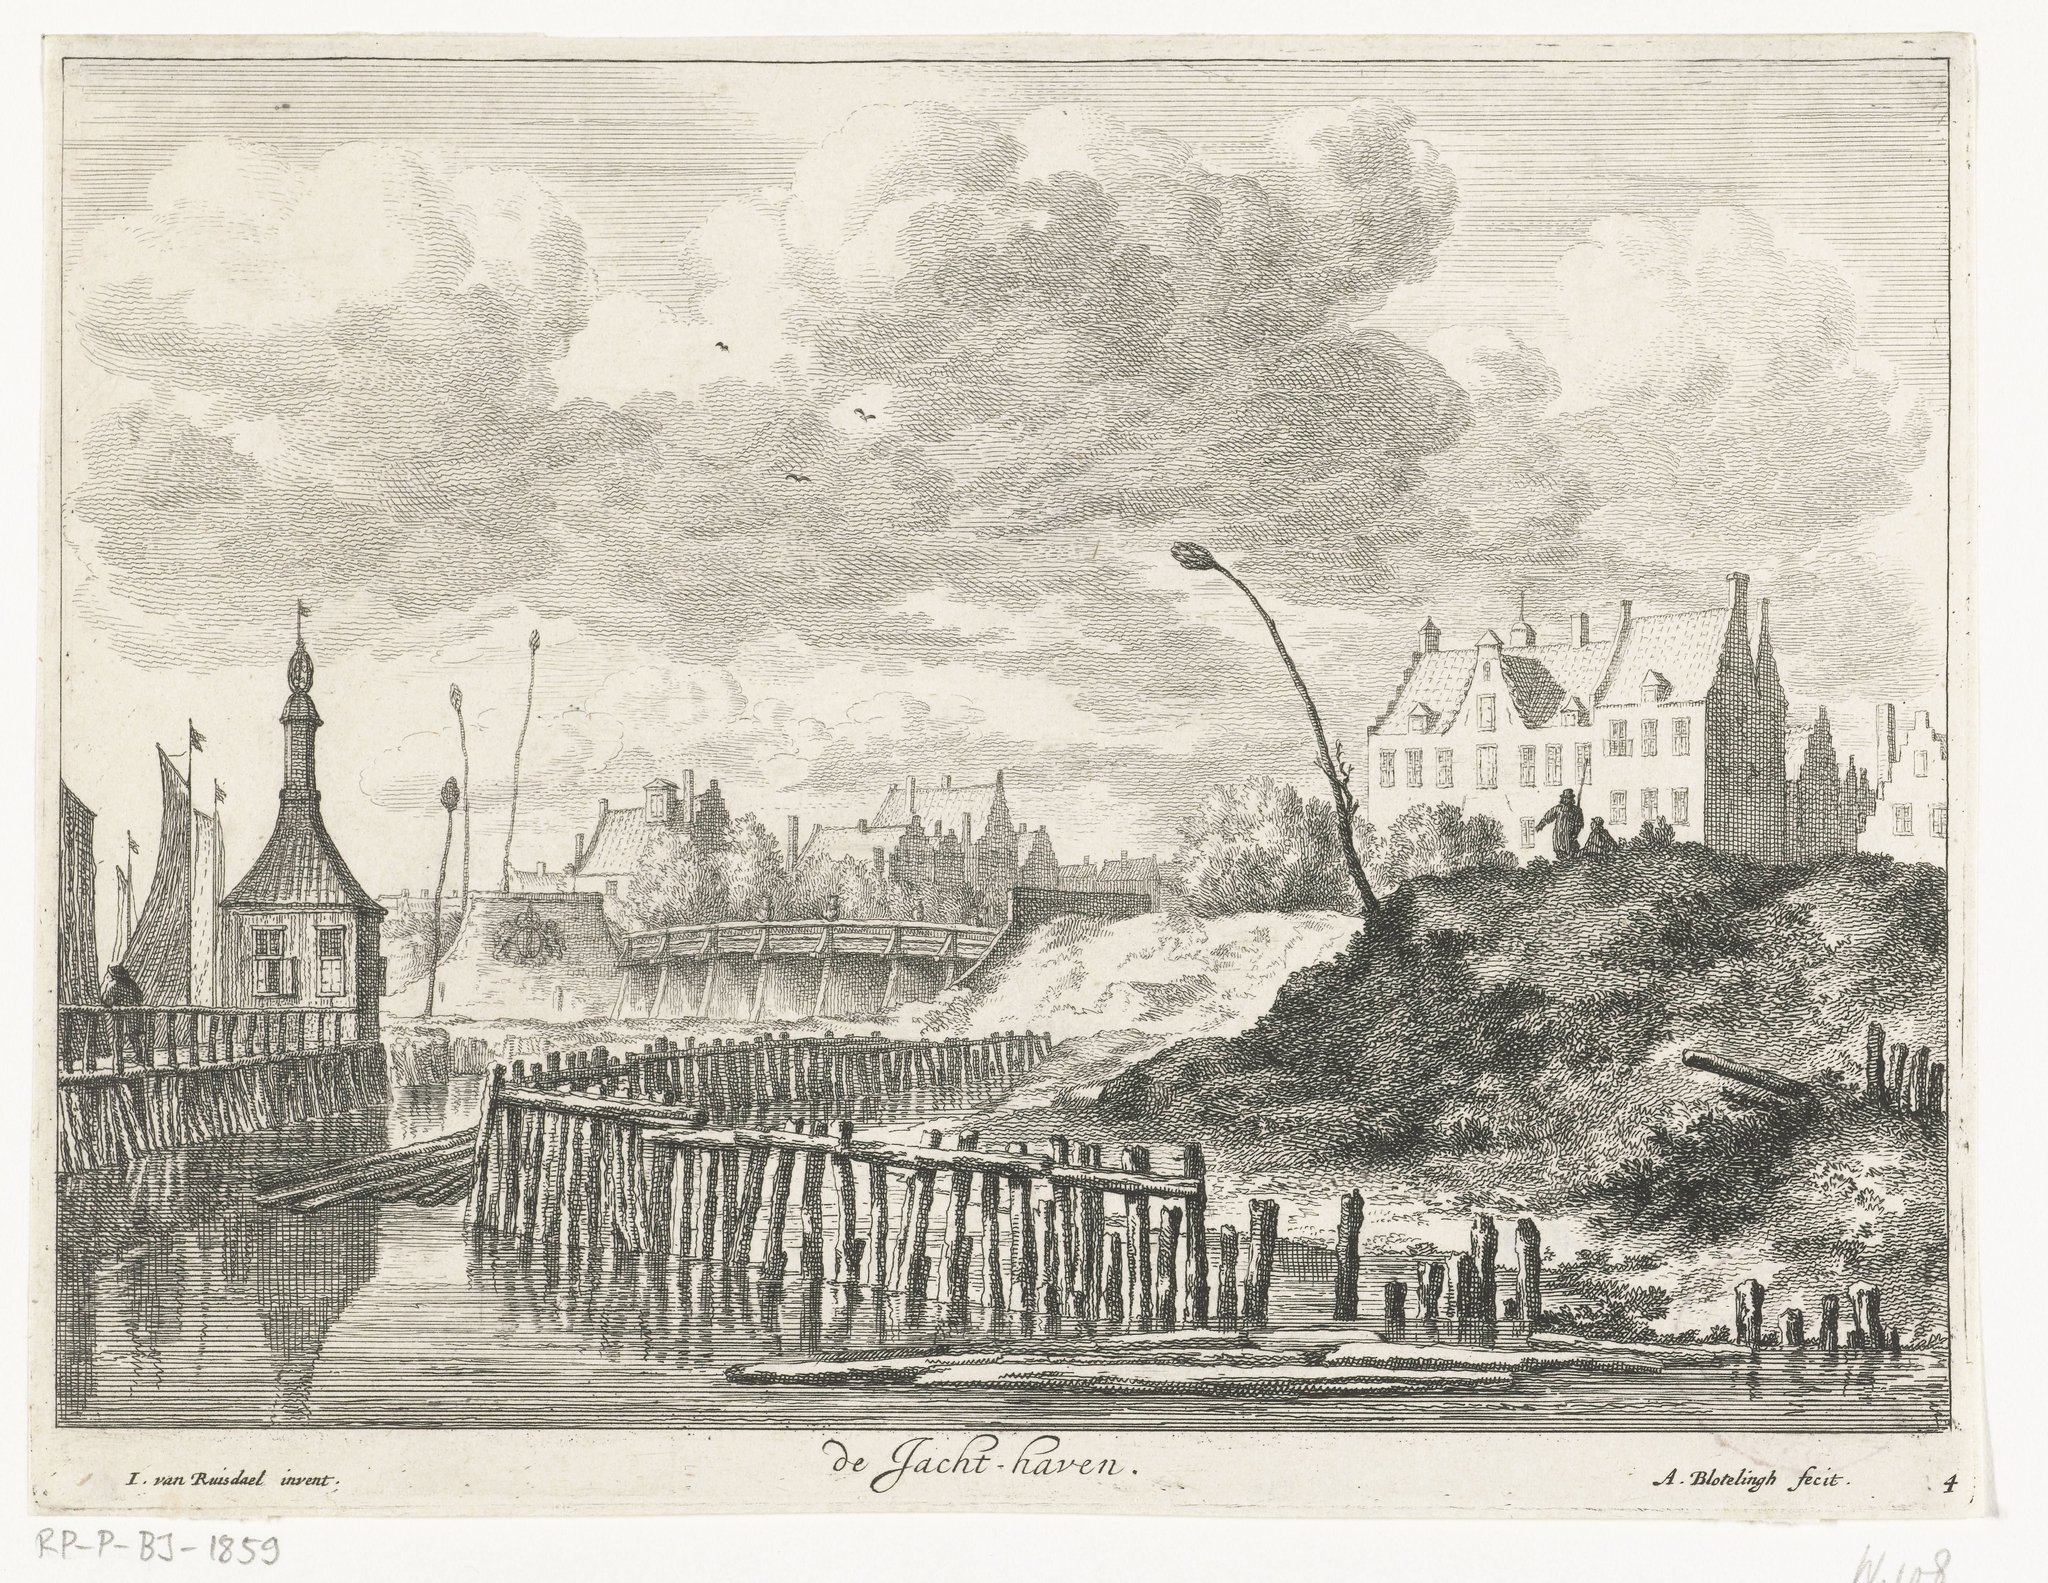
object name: print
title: Amstelgezichten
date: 1655-1690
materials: paper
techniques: etching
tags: harbour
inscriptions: collector's mark: Lugt 240